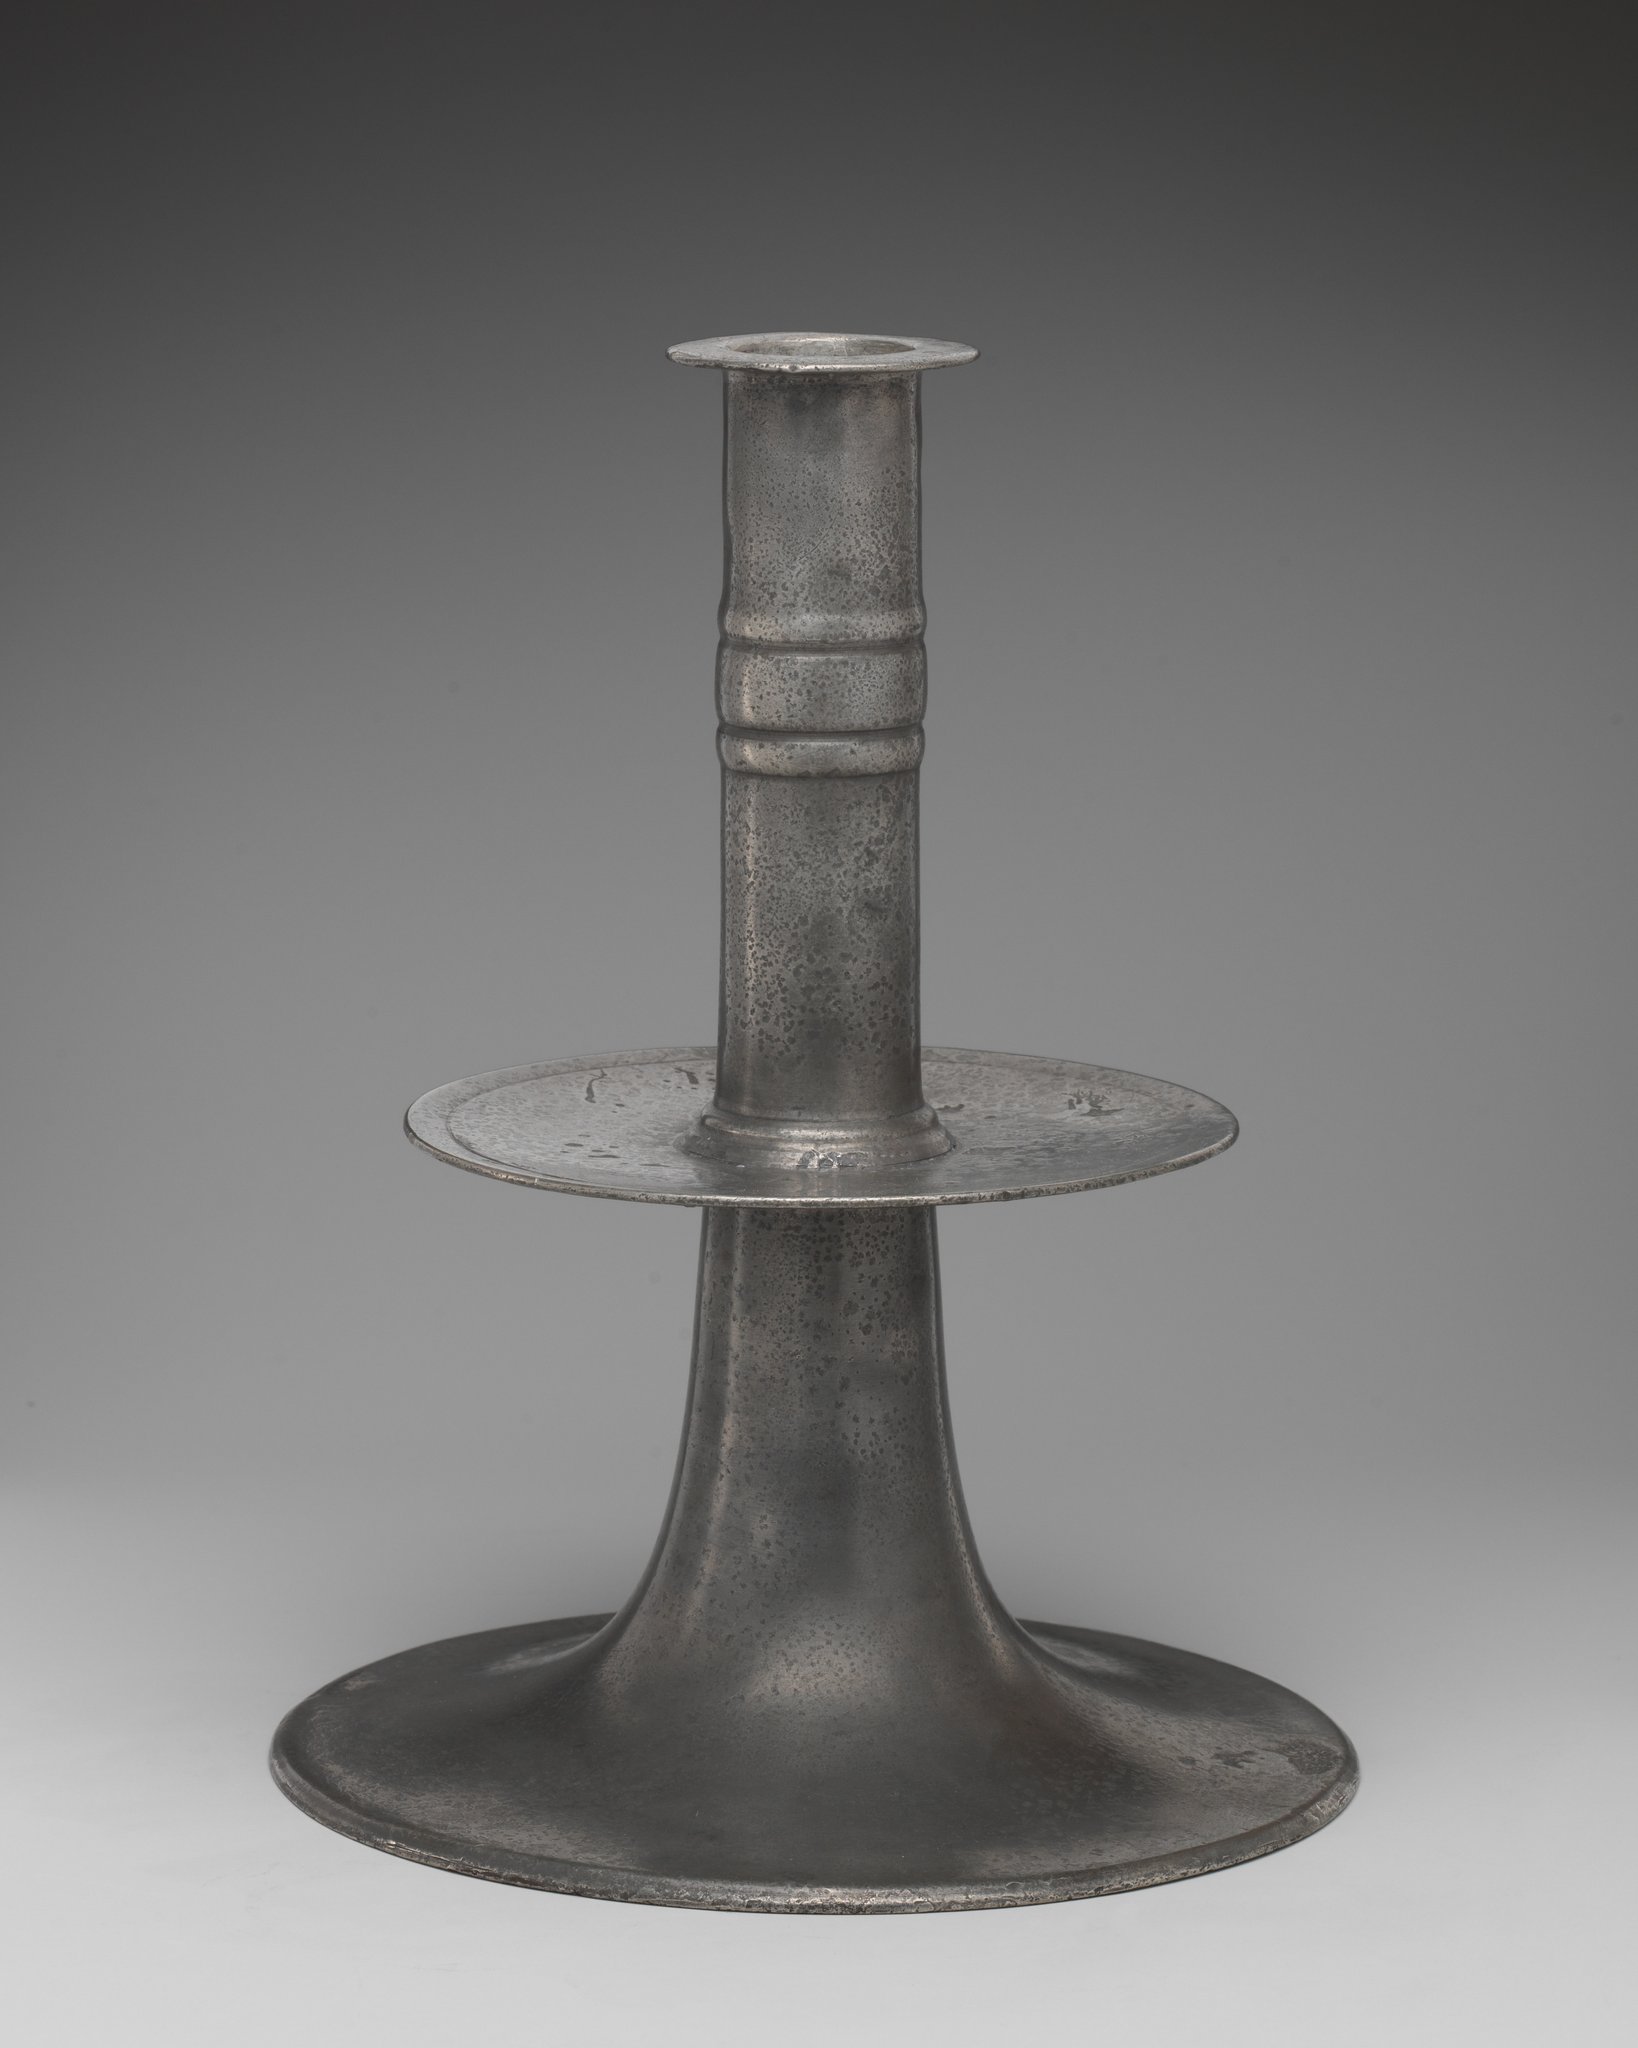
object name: candlestick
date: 1801-1900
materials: pewter